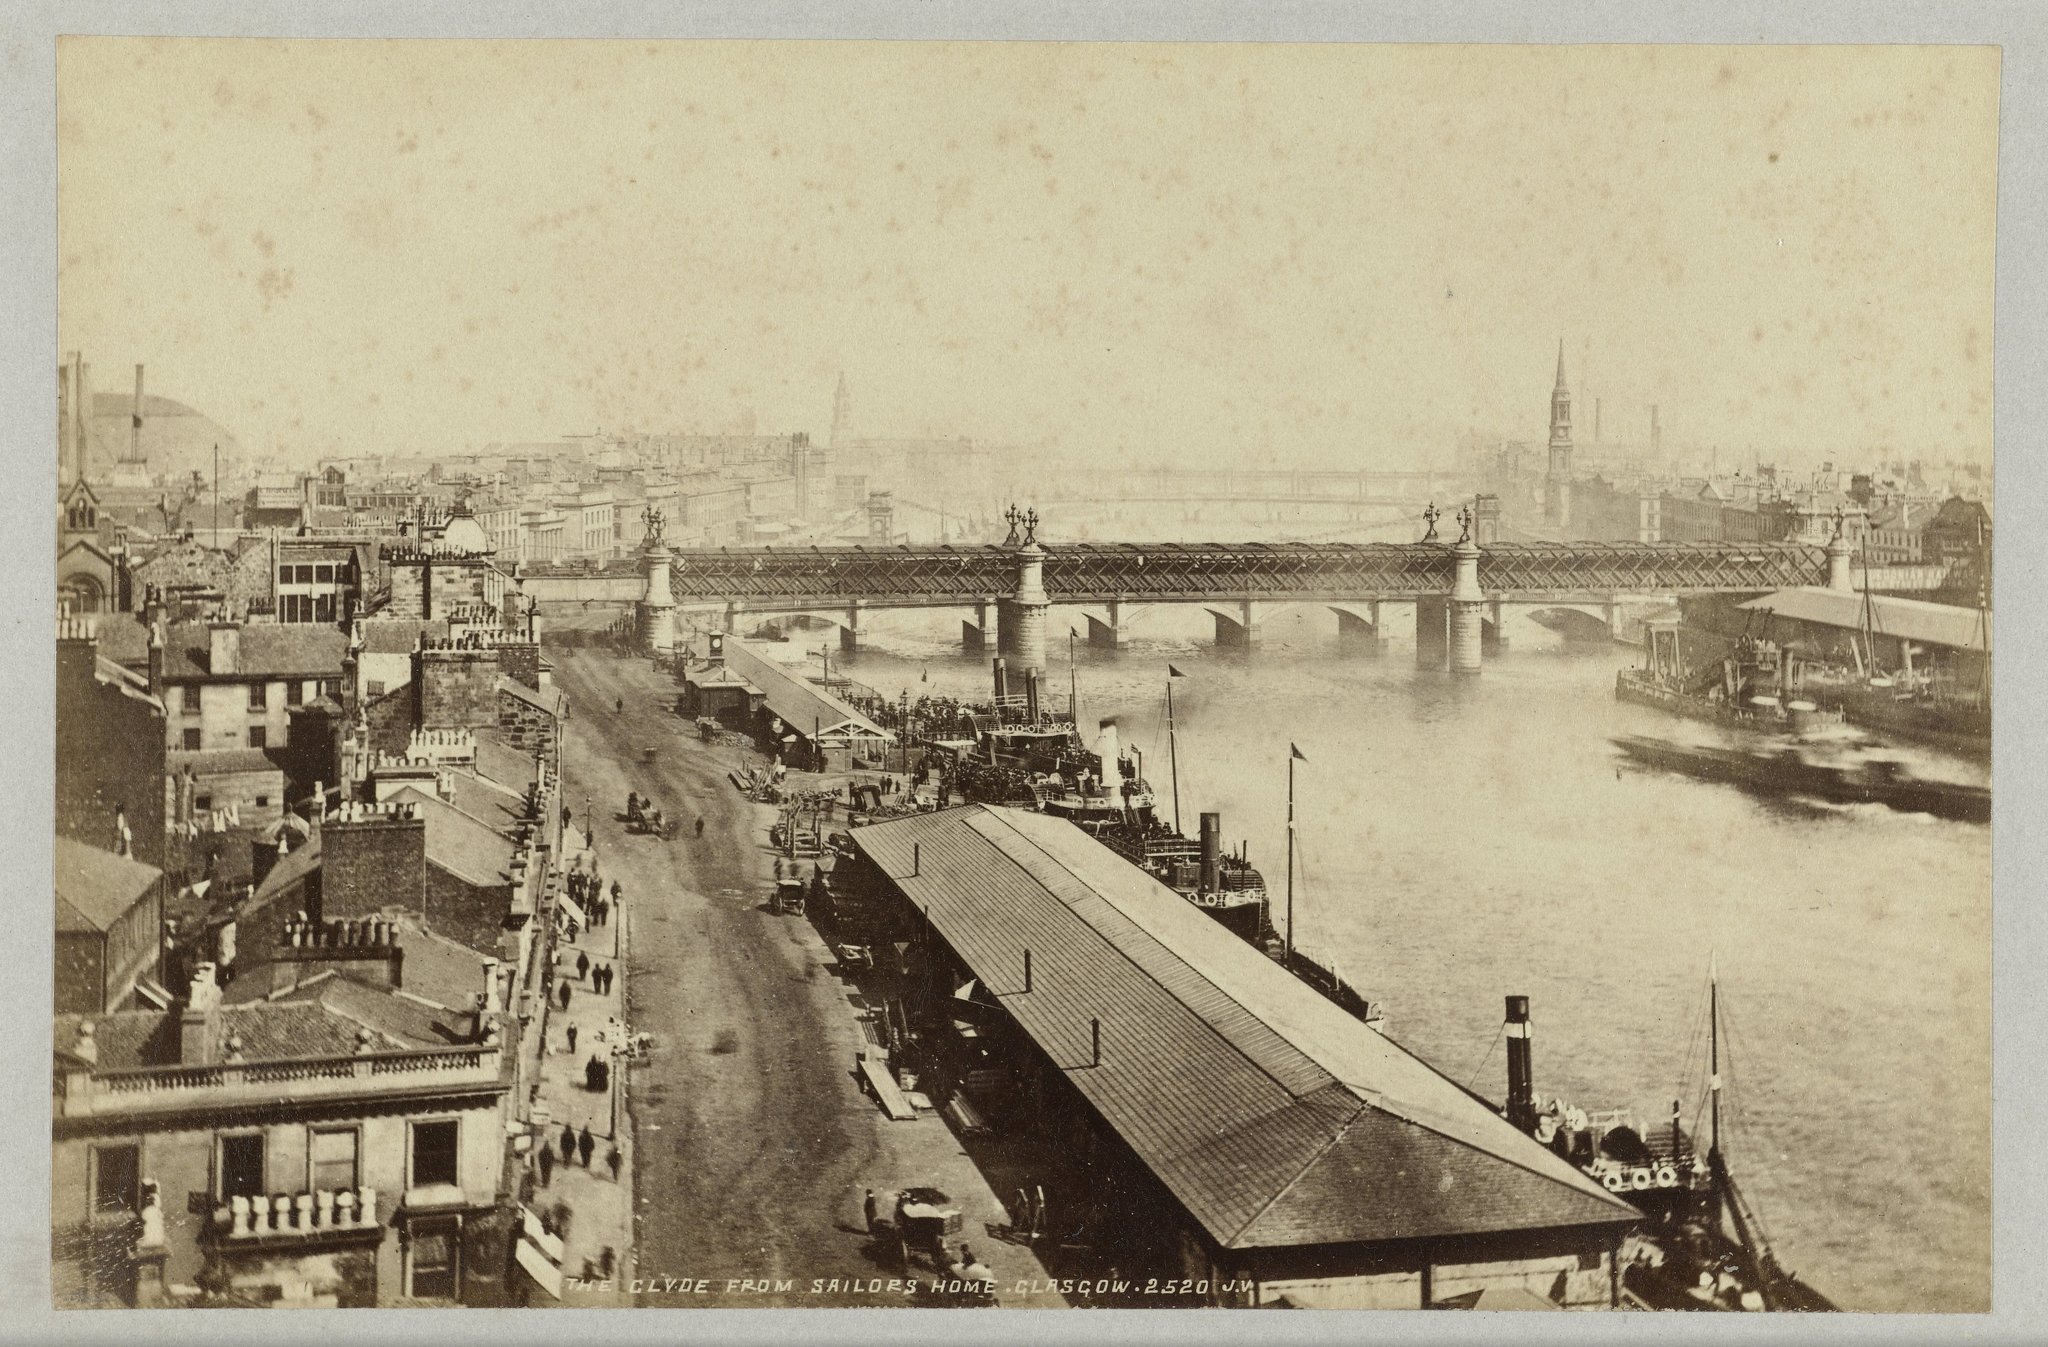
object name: photograph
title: The Clyde from Sailors Home, Glasgow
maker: james valentine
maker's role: fotograaf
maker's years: 1815-1880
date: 1851-1880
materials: cardboard, paper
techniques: albumen print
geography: glasgow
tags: city-view in general; 'veduta', bridge in city across river, canal, etc., glasgow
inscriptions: number: ‘2520’